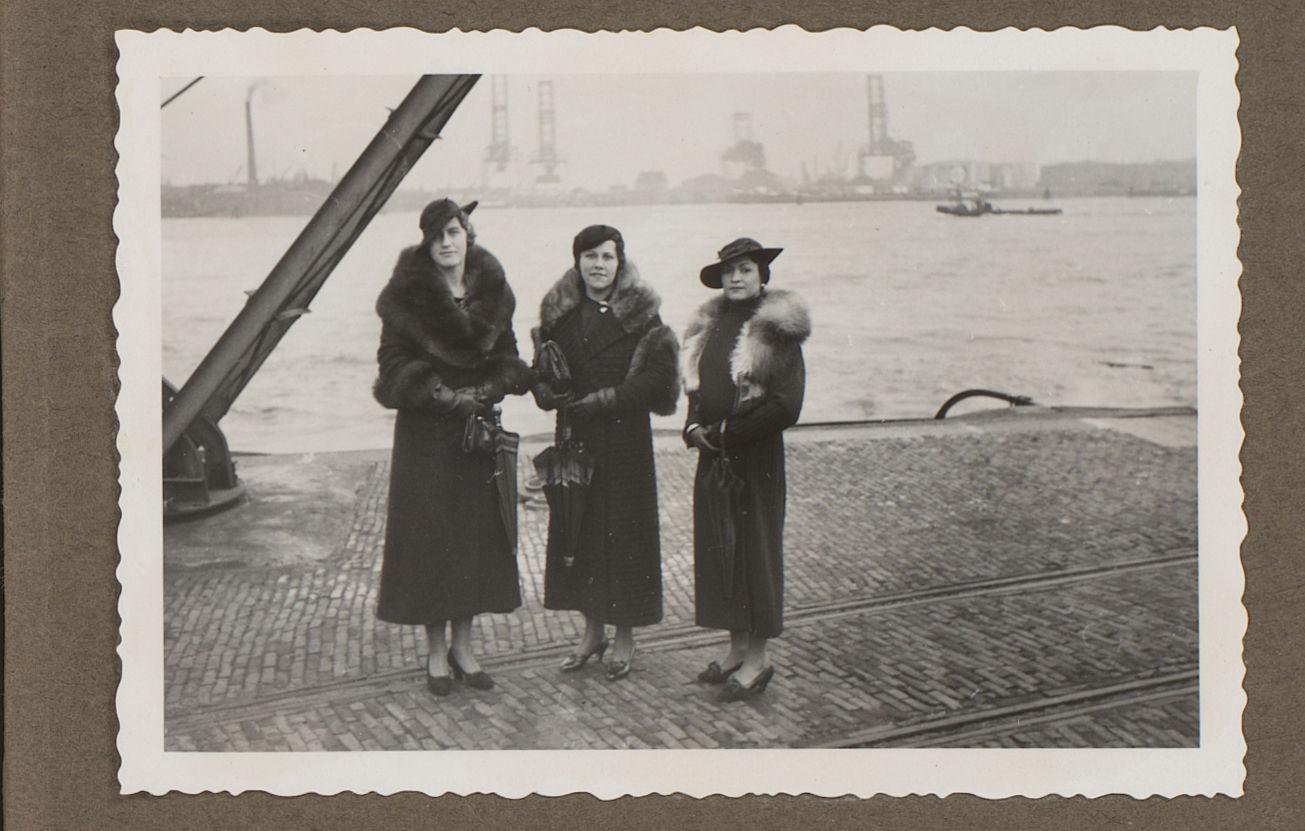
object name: photograph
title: Drie vrouwen in bontjassen in de haven, Rotterdam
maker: Anonymous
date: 1934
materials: paper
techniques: gelatin silver print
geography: rotterdam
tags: harbour, historical persons - bb - woman, rotterdam